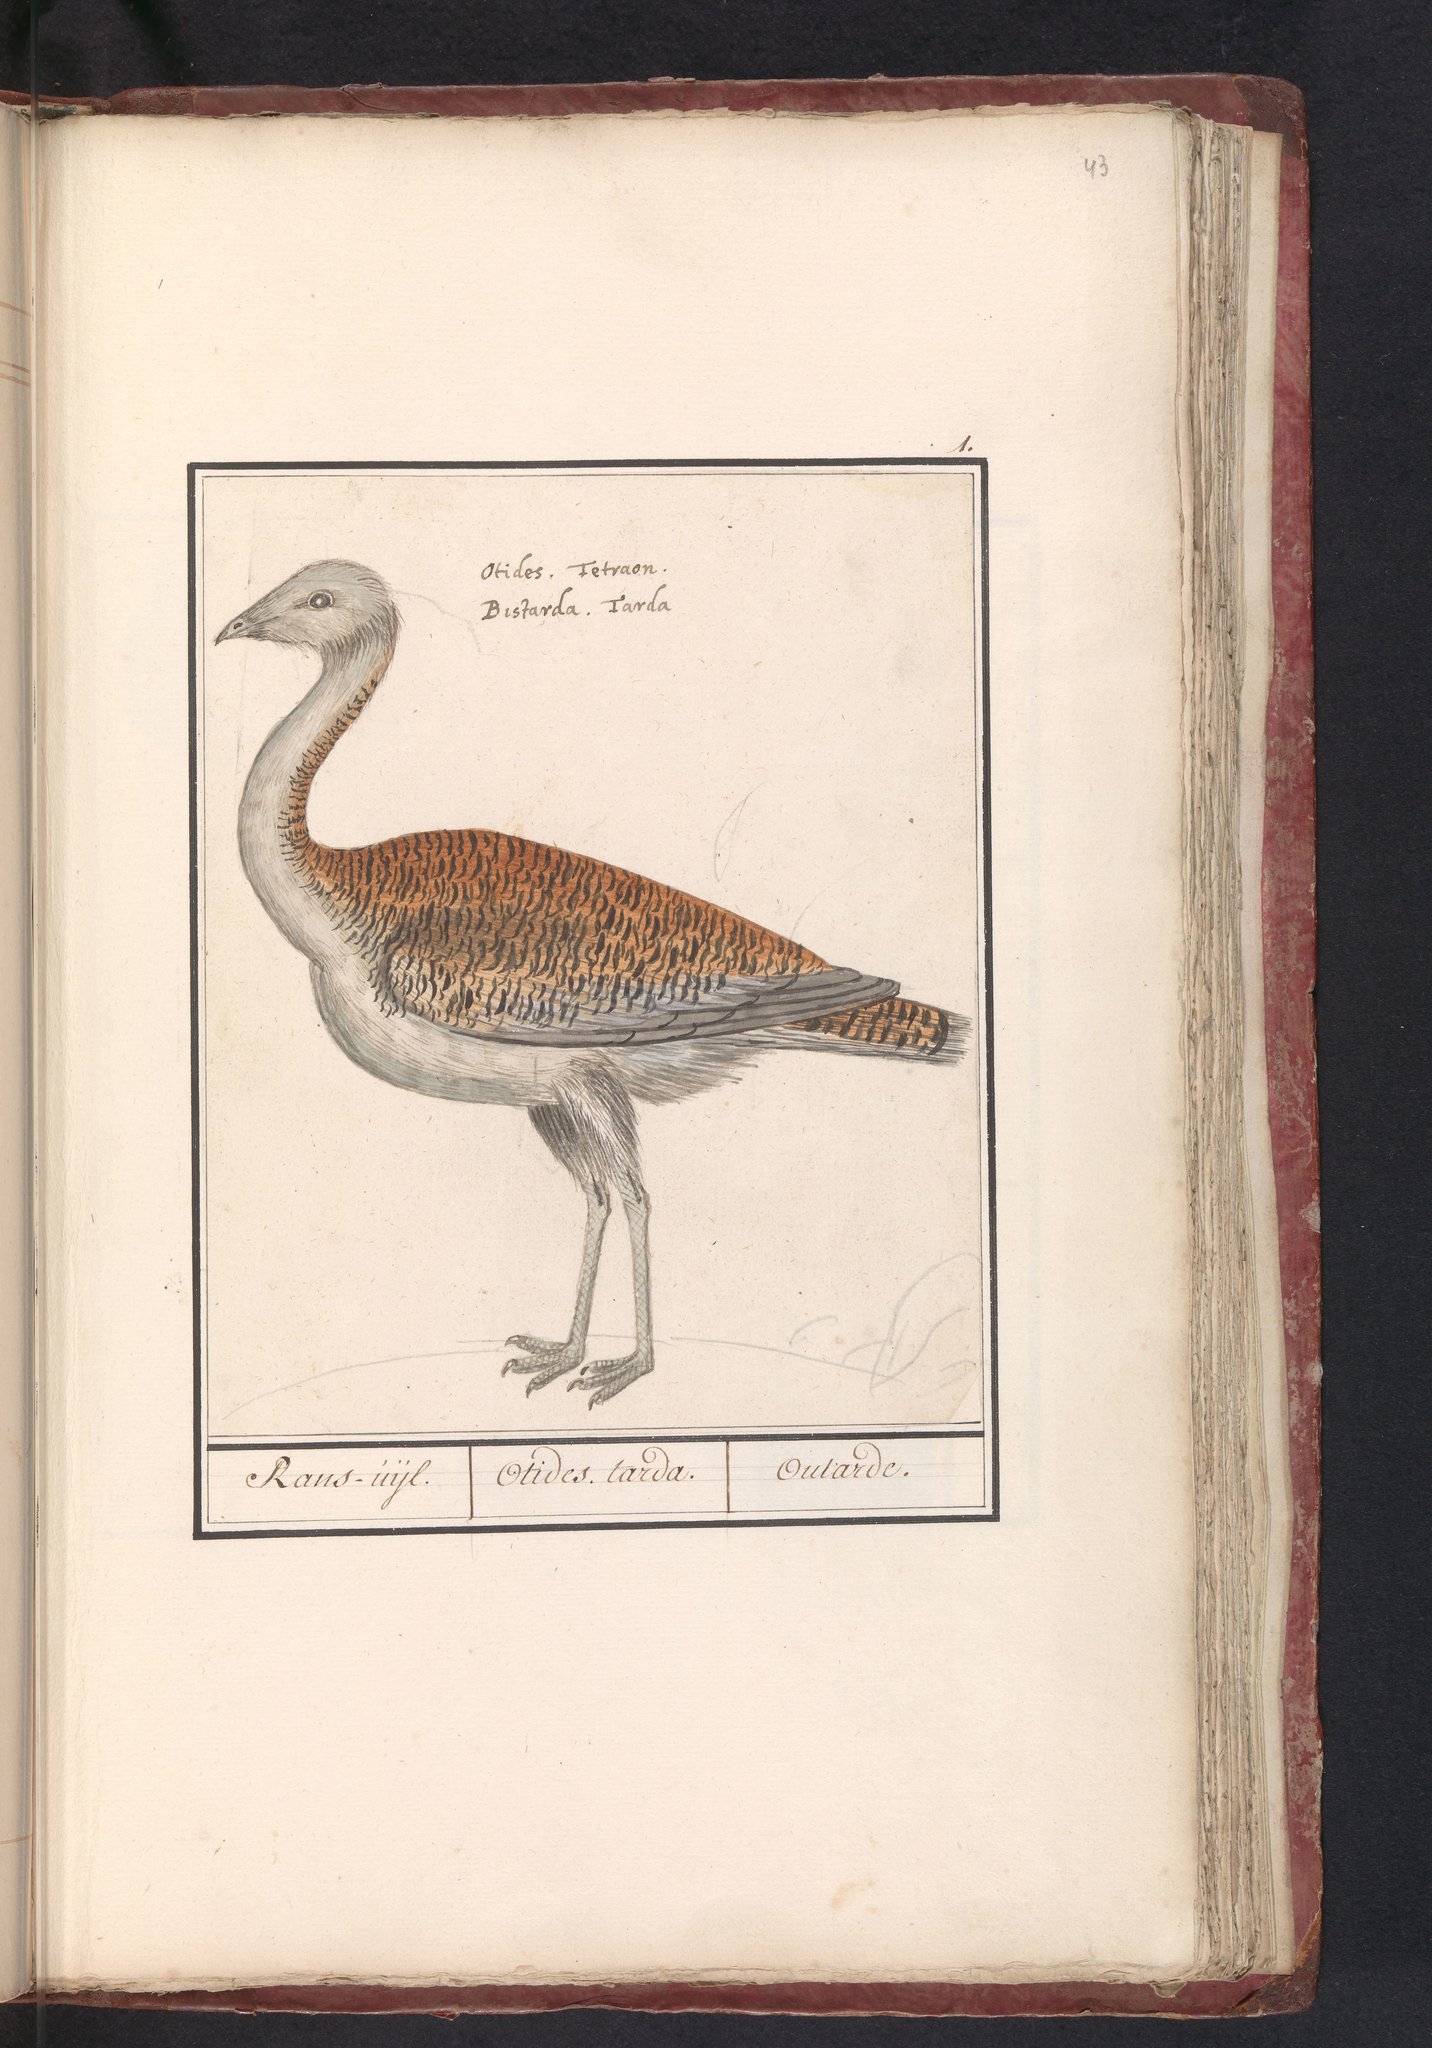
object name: drawing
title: Grote trap (Otis tarda)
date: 1596-1610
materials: paint, ink, paper, pencil, watercolor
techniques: brush, pen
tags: walker and runner birds: great bustard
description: Grote trap. Genummerd rechtsboven: 1. Bovenaan de Latijnse naam. Onderdeel van het eerste album met tekeningen van vogels. Derde van twaalf albums met tekeningen van dieren, vogels en planten bekend rond 1600, gemaakt in opdracht van keizer Rudolf II. Met toelichting in Nederlands, Latijn en Frans.